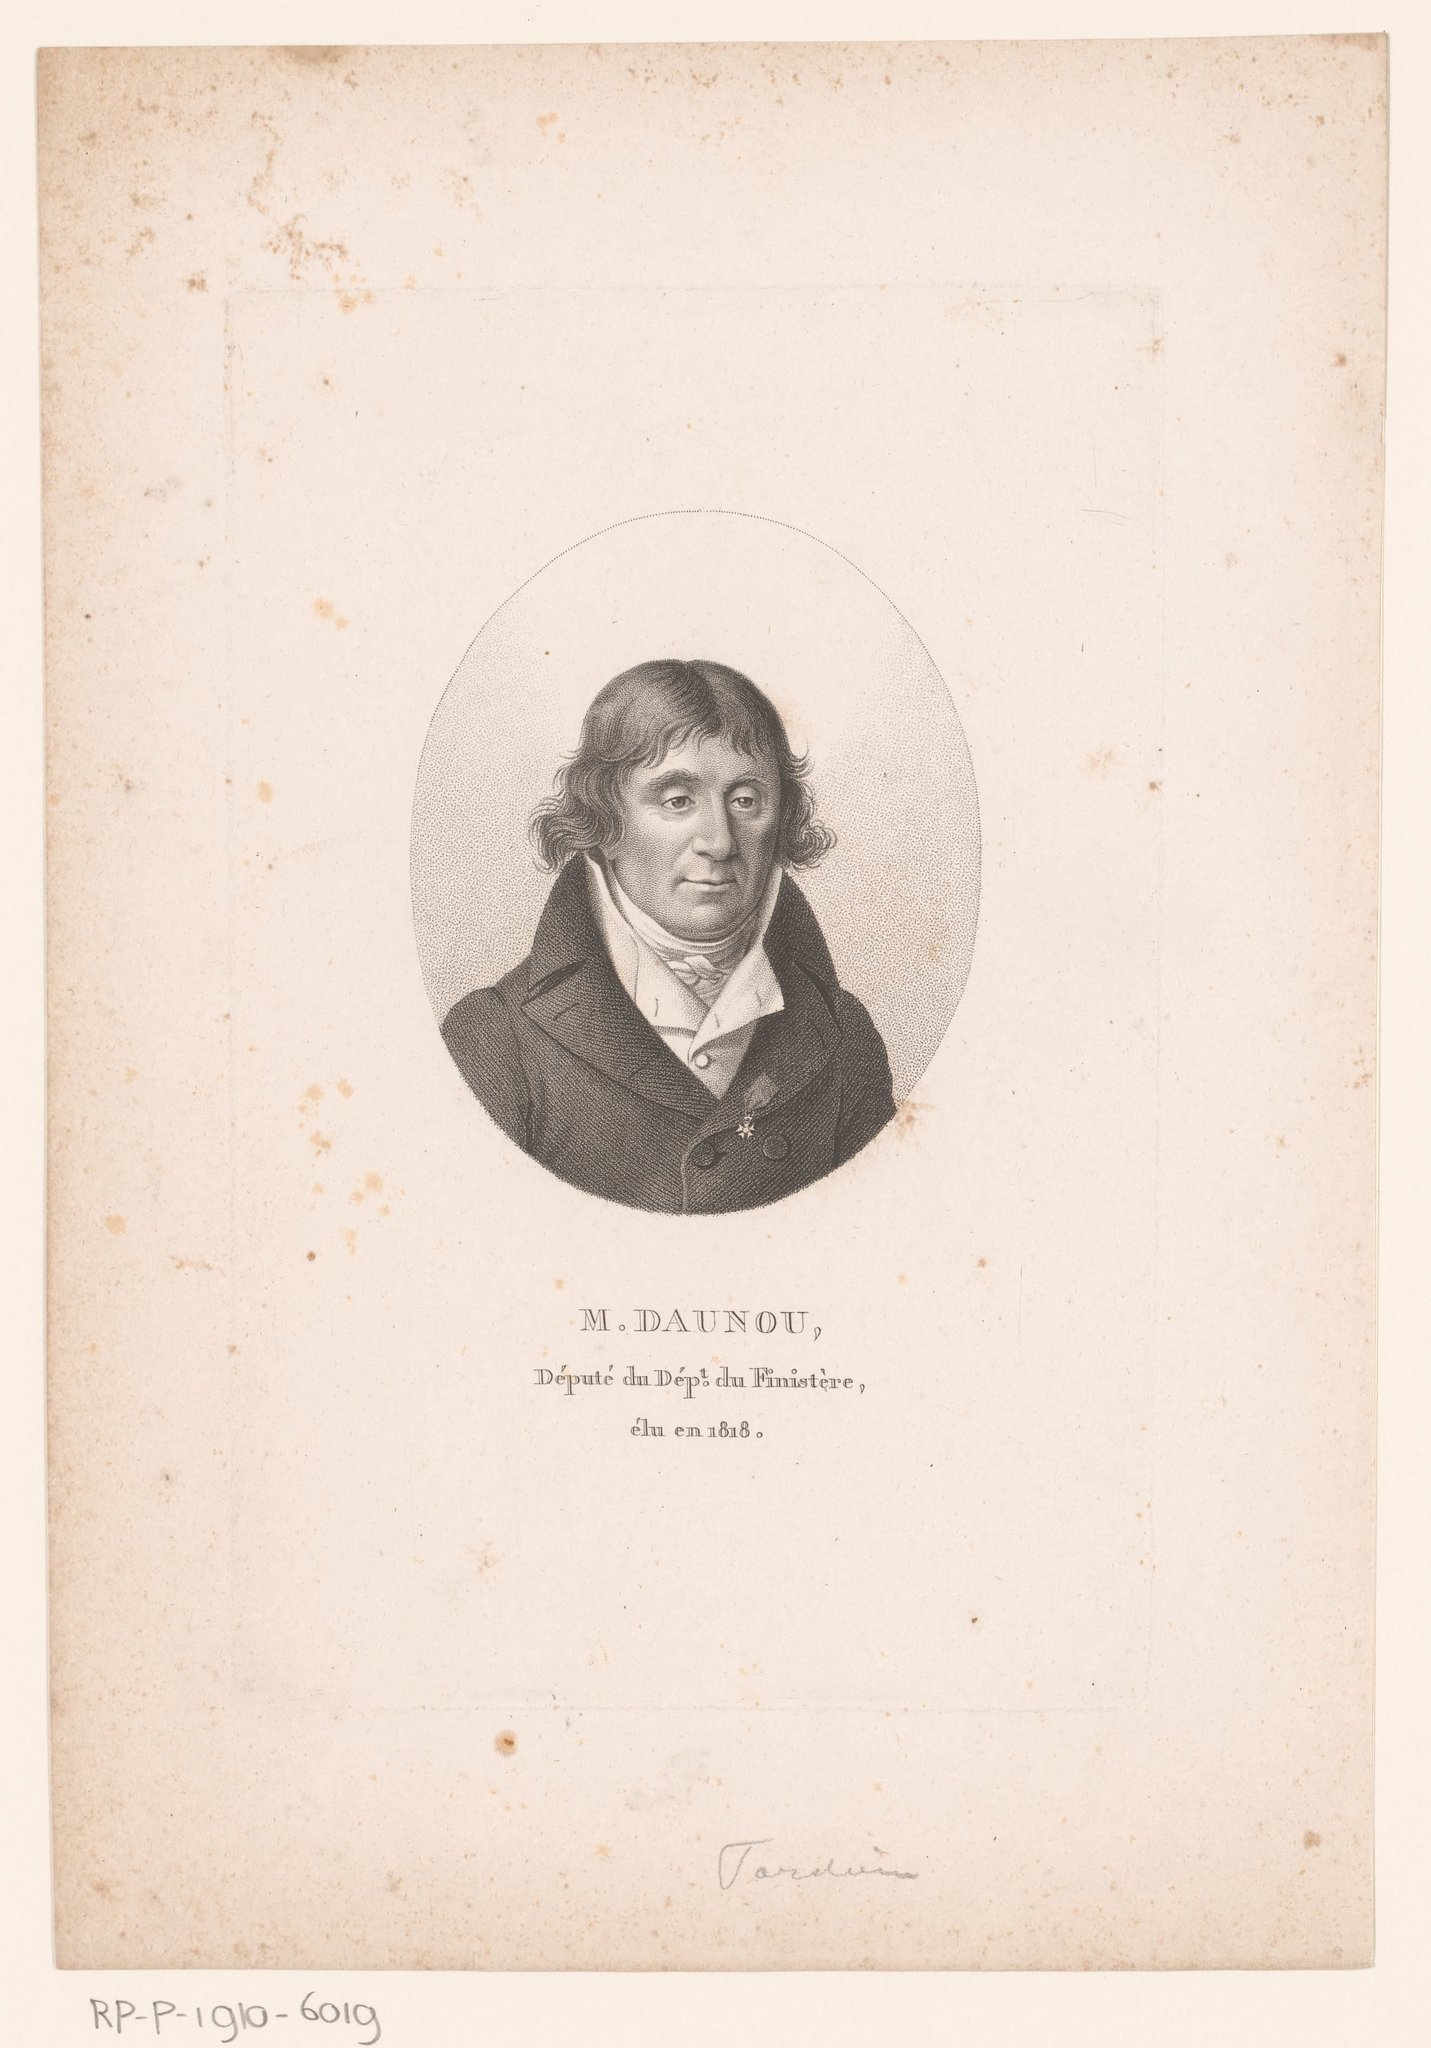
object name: print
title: Portret van Pierre Claude François Daunou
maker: ambroise tardieu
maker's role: print maker, printer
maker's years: 1788-1841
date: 1820-1821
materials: paper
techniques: engraving, roulette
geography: paris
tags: politician, historical persons, politician, e.g. party leader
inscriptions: collector's mark: Lugt 2228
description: Prent uit: Tardieu, Ambroise. Portraits des députés, écrivains et pairs constitutionnels, défenseurs invariables de la charte et de la loi des élections du 5 février 1817. Parijs: Tardieu, Ambroise, 1820-1821.